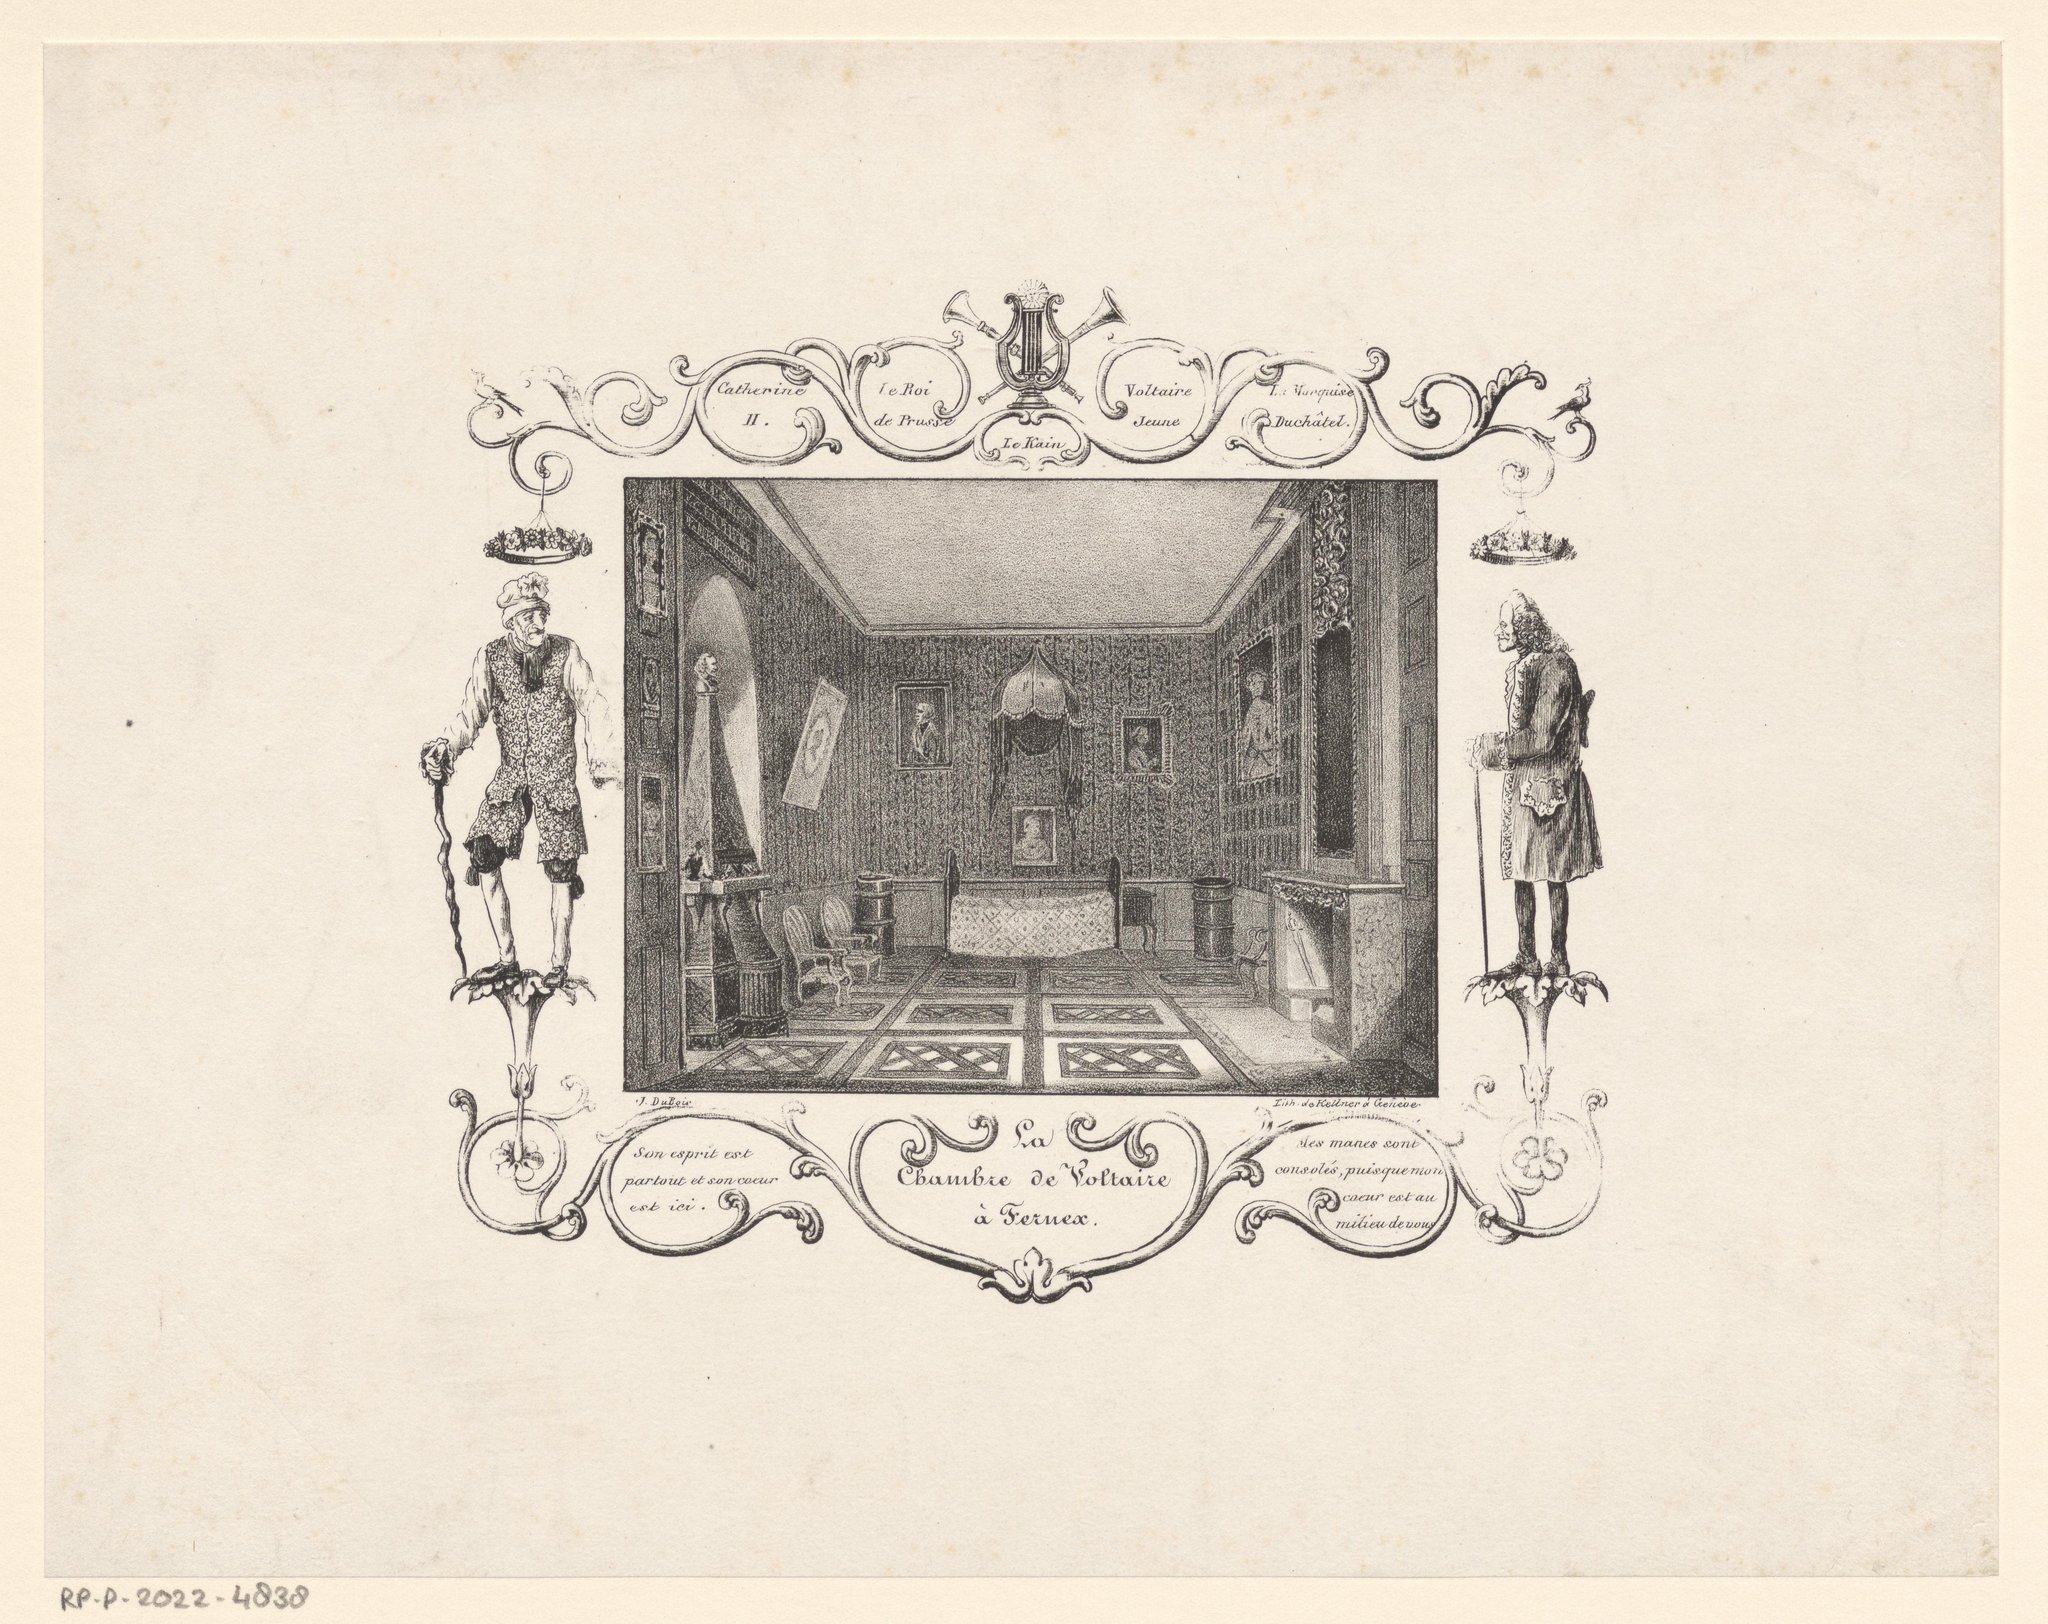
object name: print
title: Interieur van de kamer van Voltaire te Ferney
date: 1835-1842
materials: paper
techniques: lithograph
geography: geneva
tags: voltaire, historical persons, portrait of a writer, bedroom